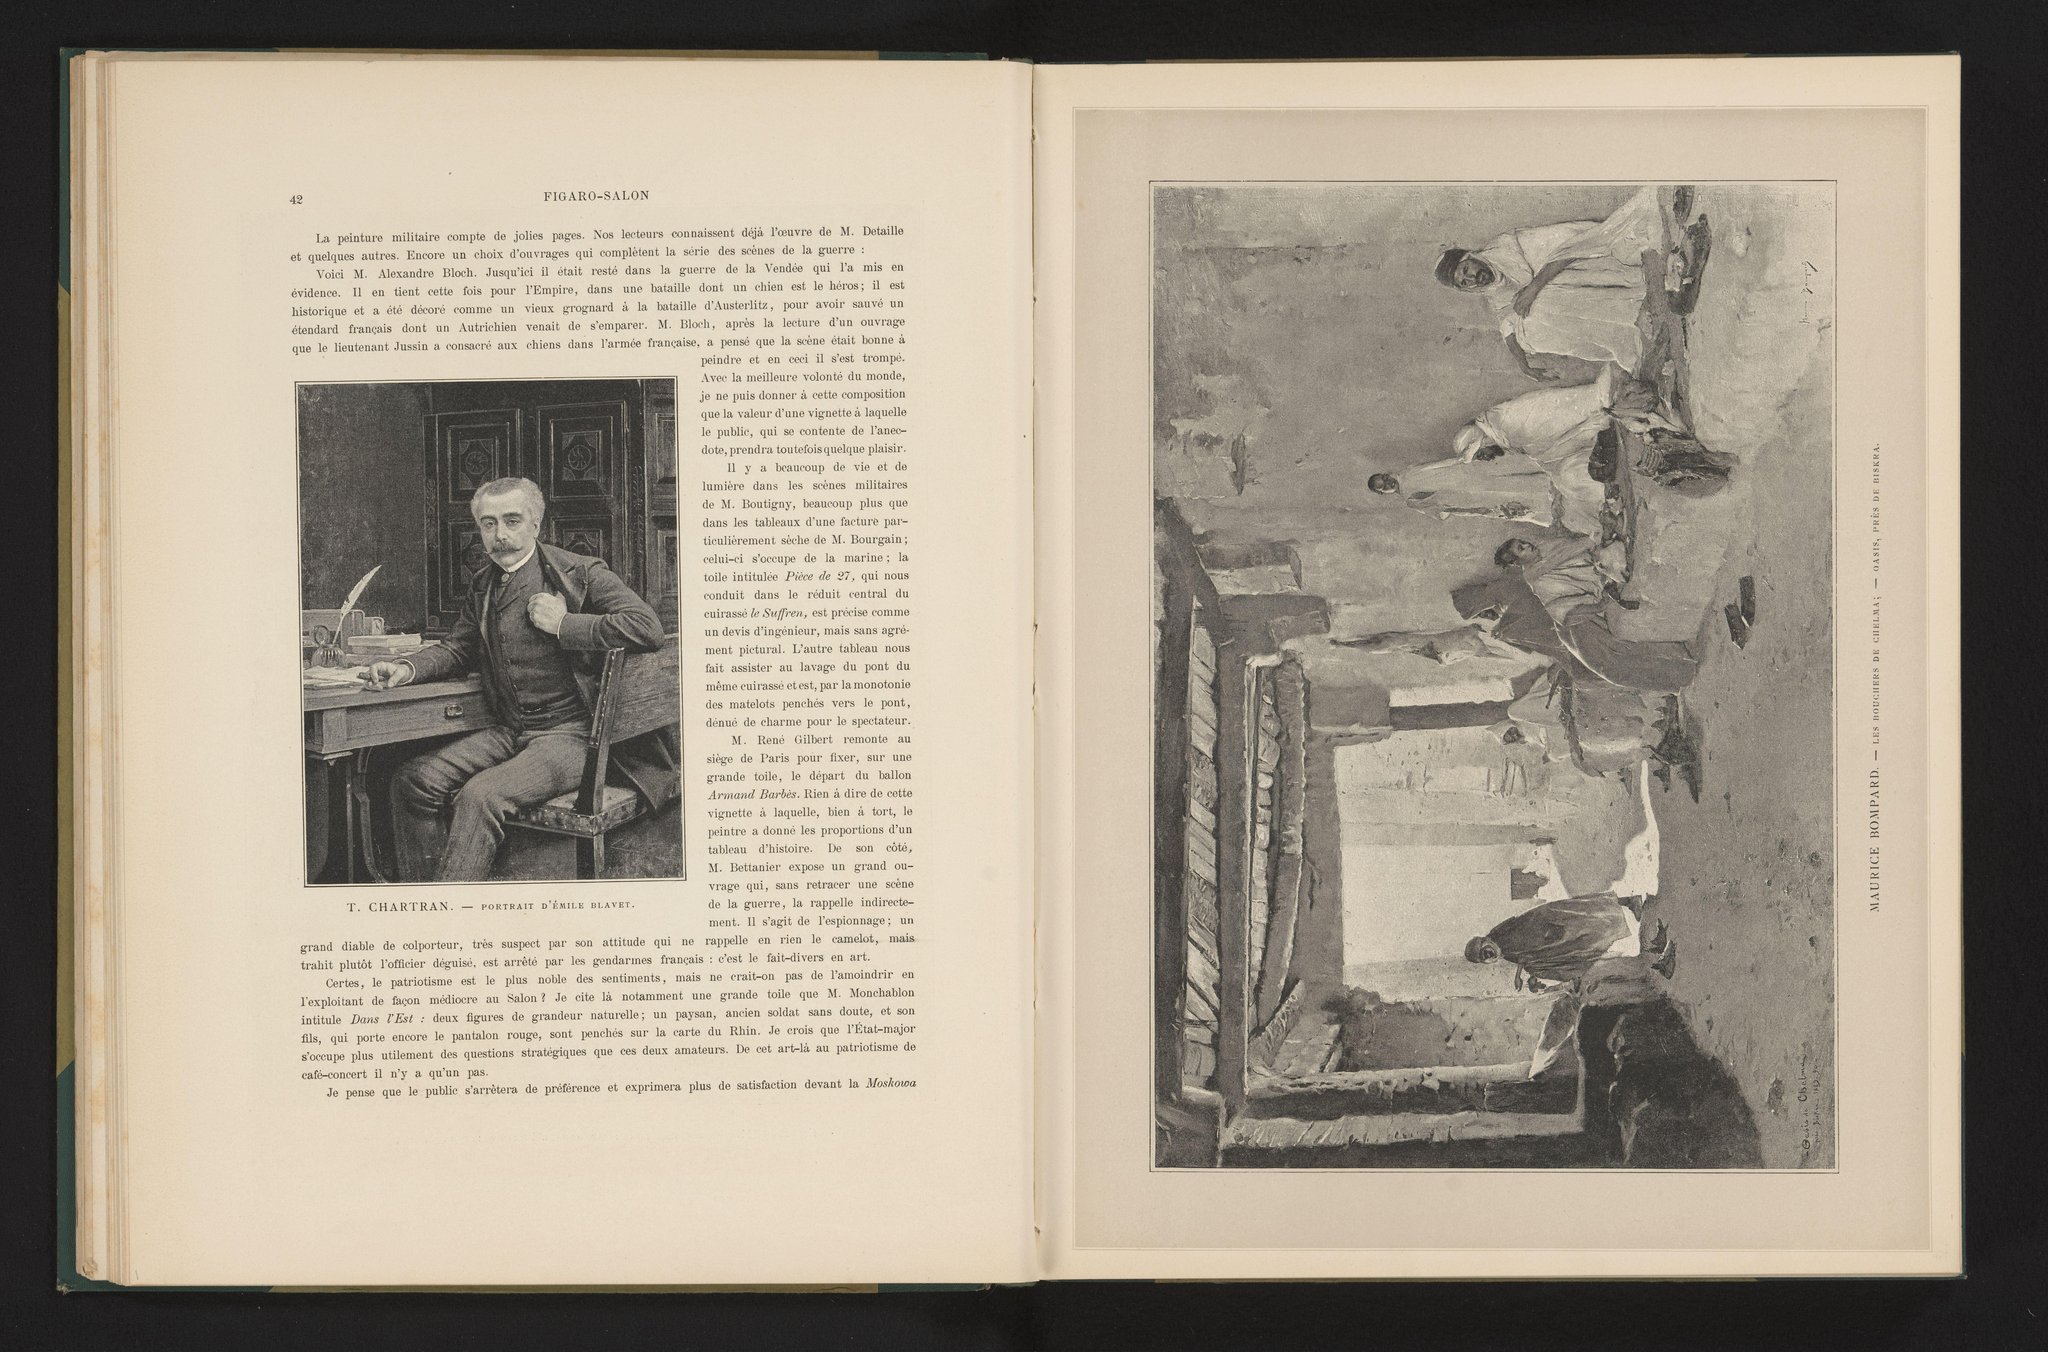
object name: photomechanical print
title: Oasis de Chelma près Biskra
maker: Anonymous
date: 1885-1901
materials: paper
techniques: autotype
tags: butcher, slaughterman, street (+ city(-scape) with figures, staffage)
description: Prent tegenover pagina 42 van Figaro-Salon.